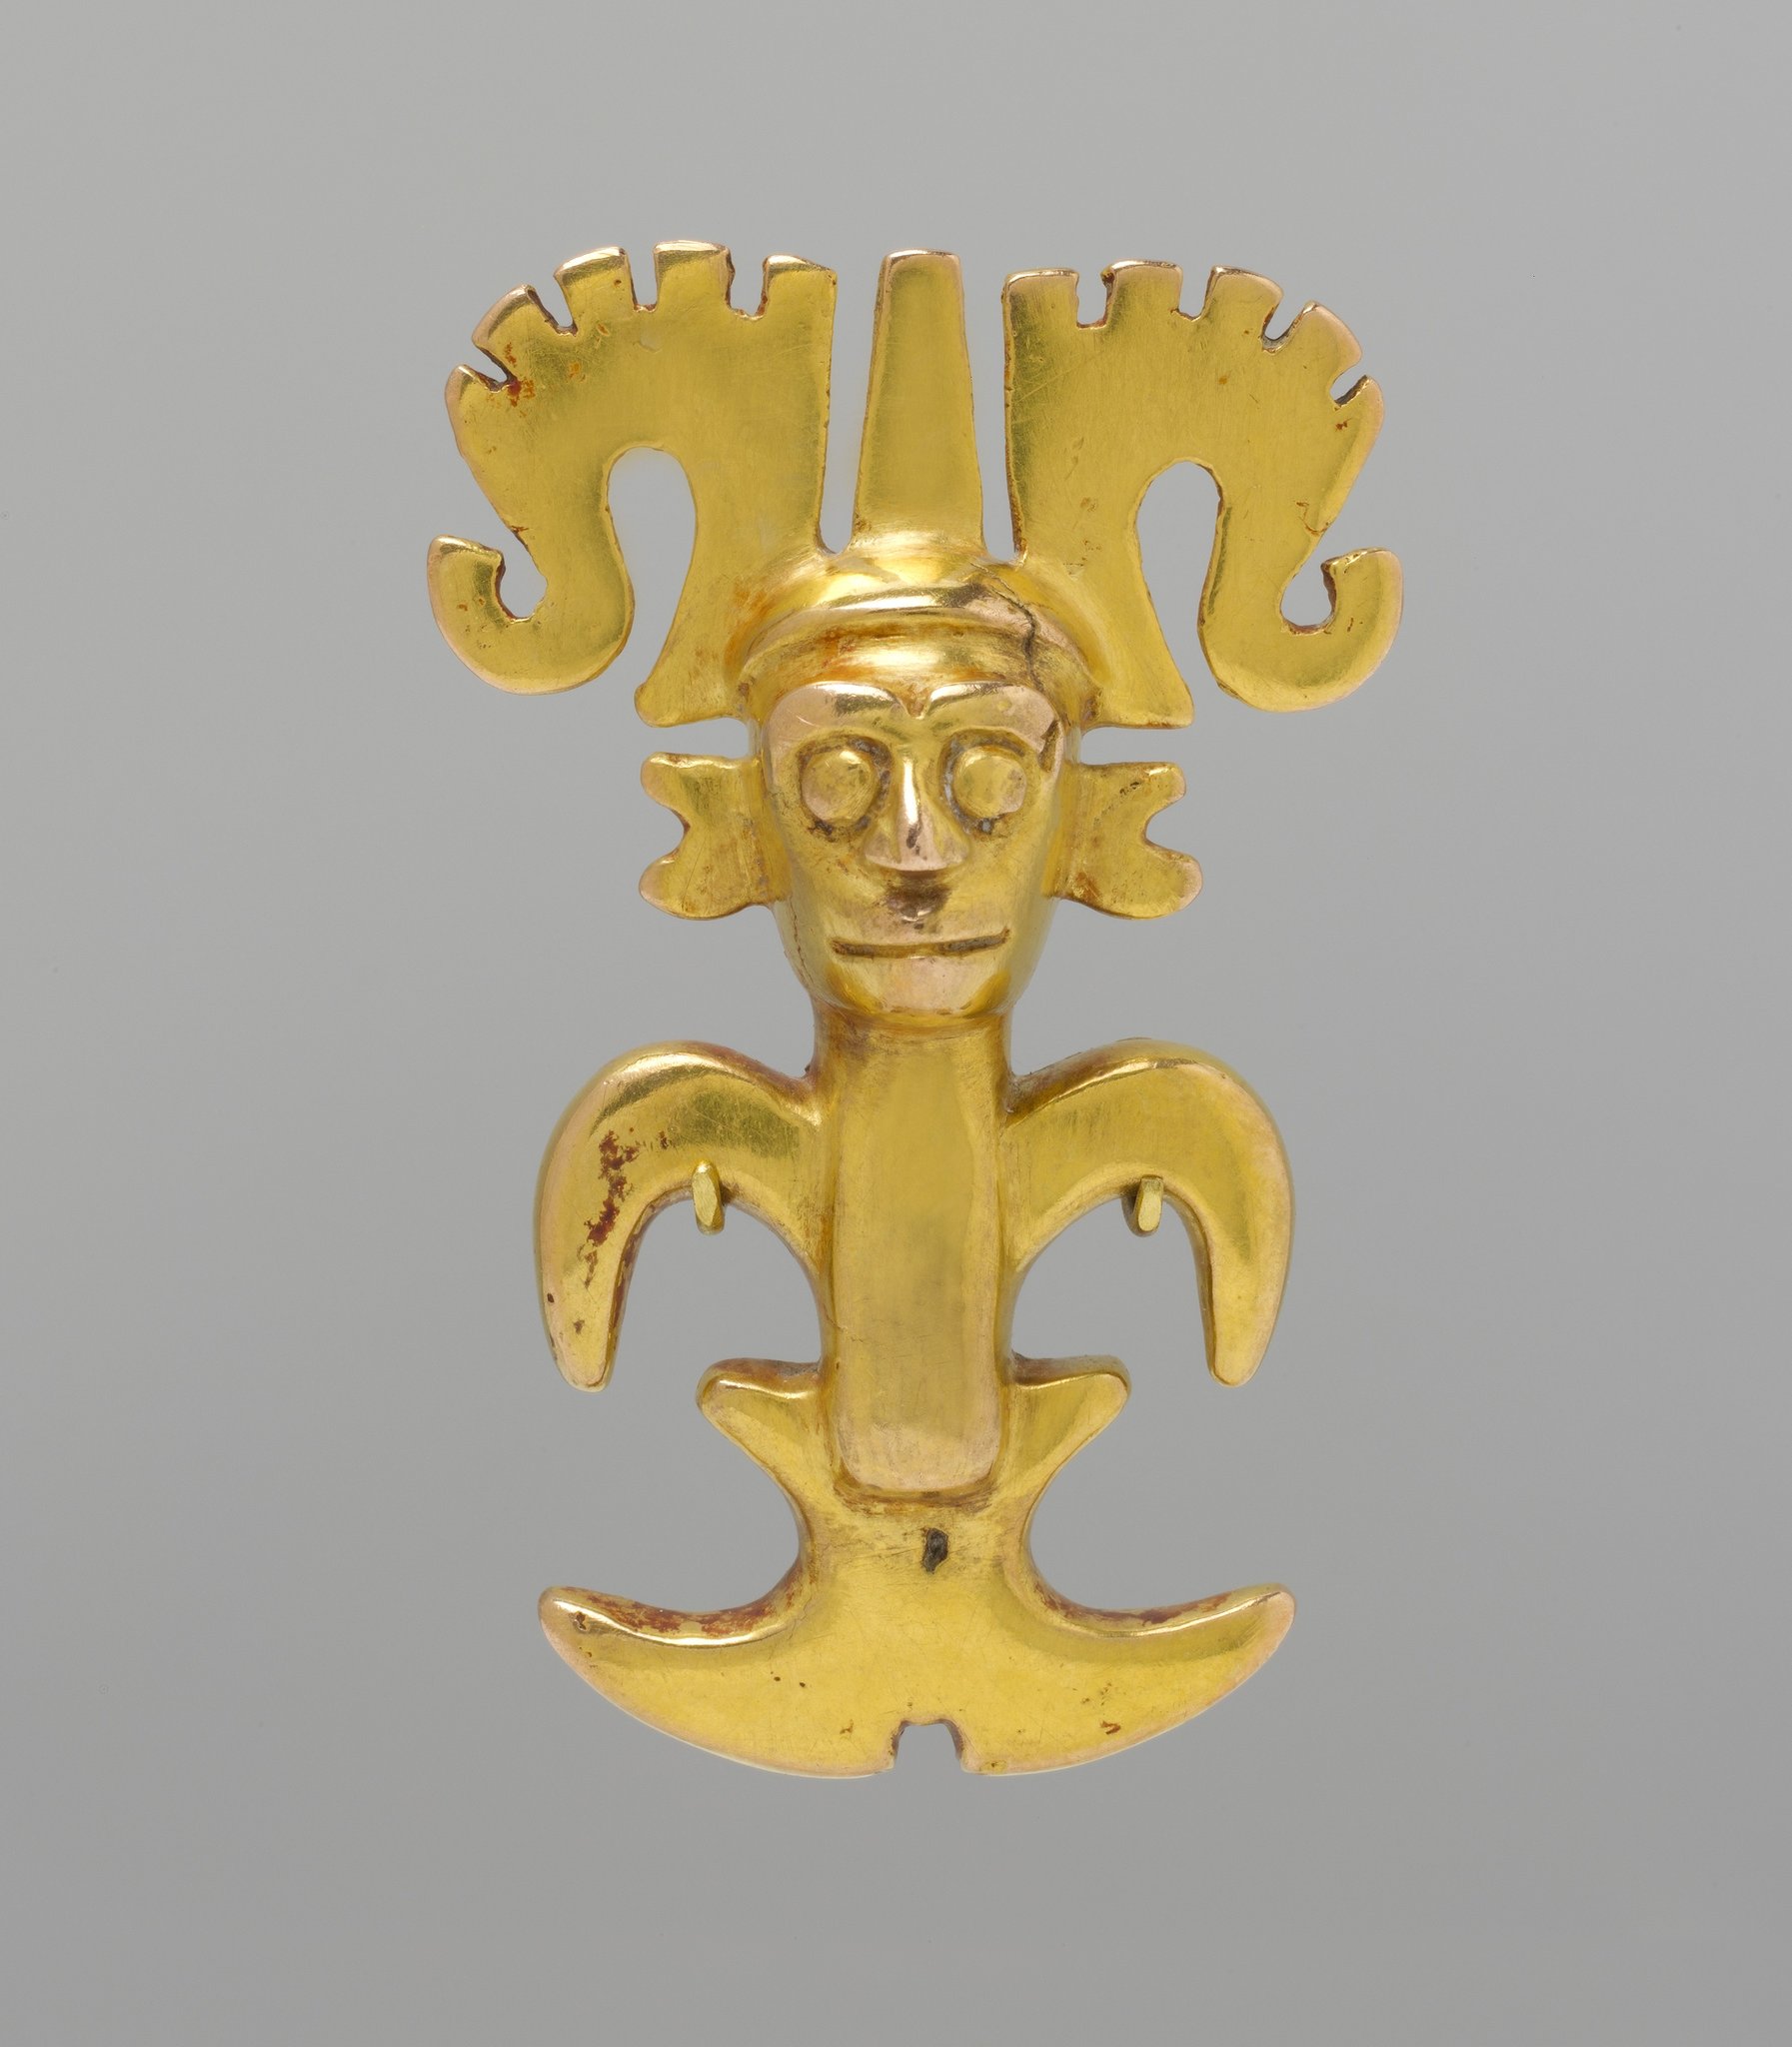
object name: pendant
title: Stylized Figure Pendant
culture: international style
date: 401-1000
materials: gold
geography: panama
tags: faces